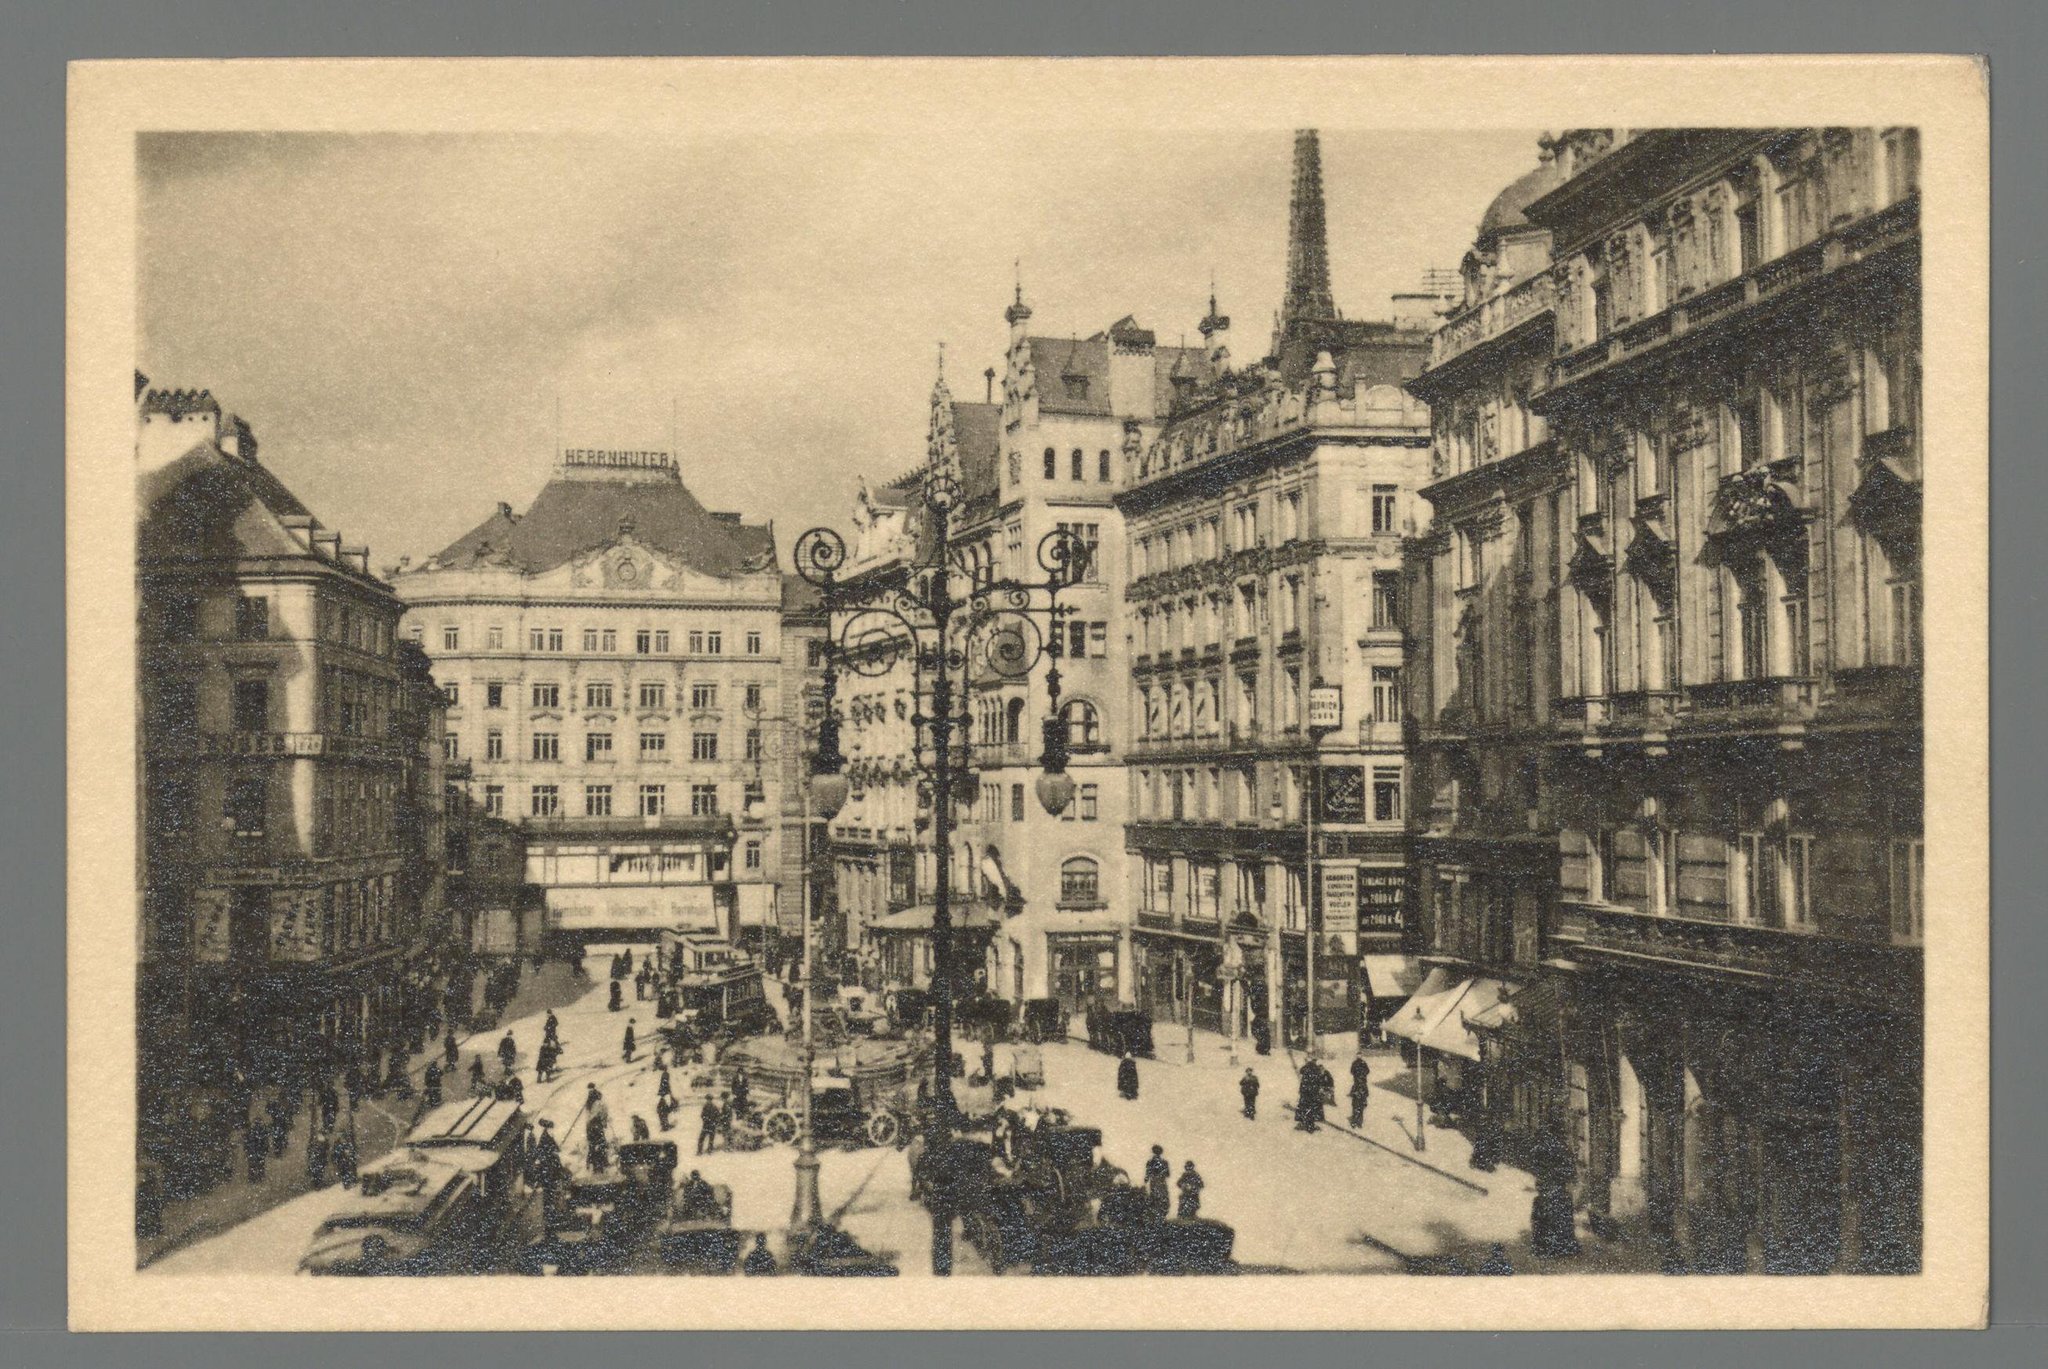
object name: ansichtkaart, prentbriefkaart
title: Wien, I. Neuer Markt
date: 1904-1930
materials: paper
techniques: gelatin silver print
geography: vienna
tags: market, street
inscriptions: inscription: ‘K.L. Wien’